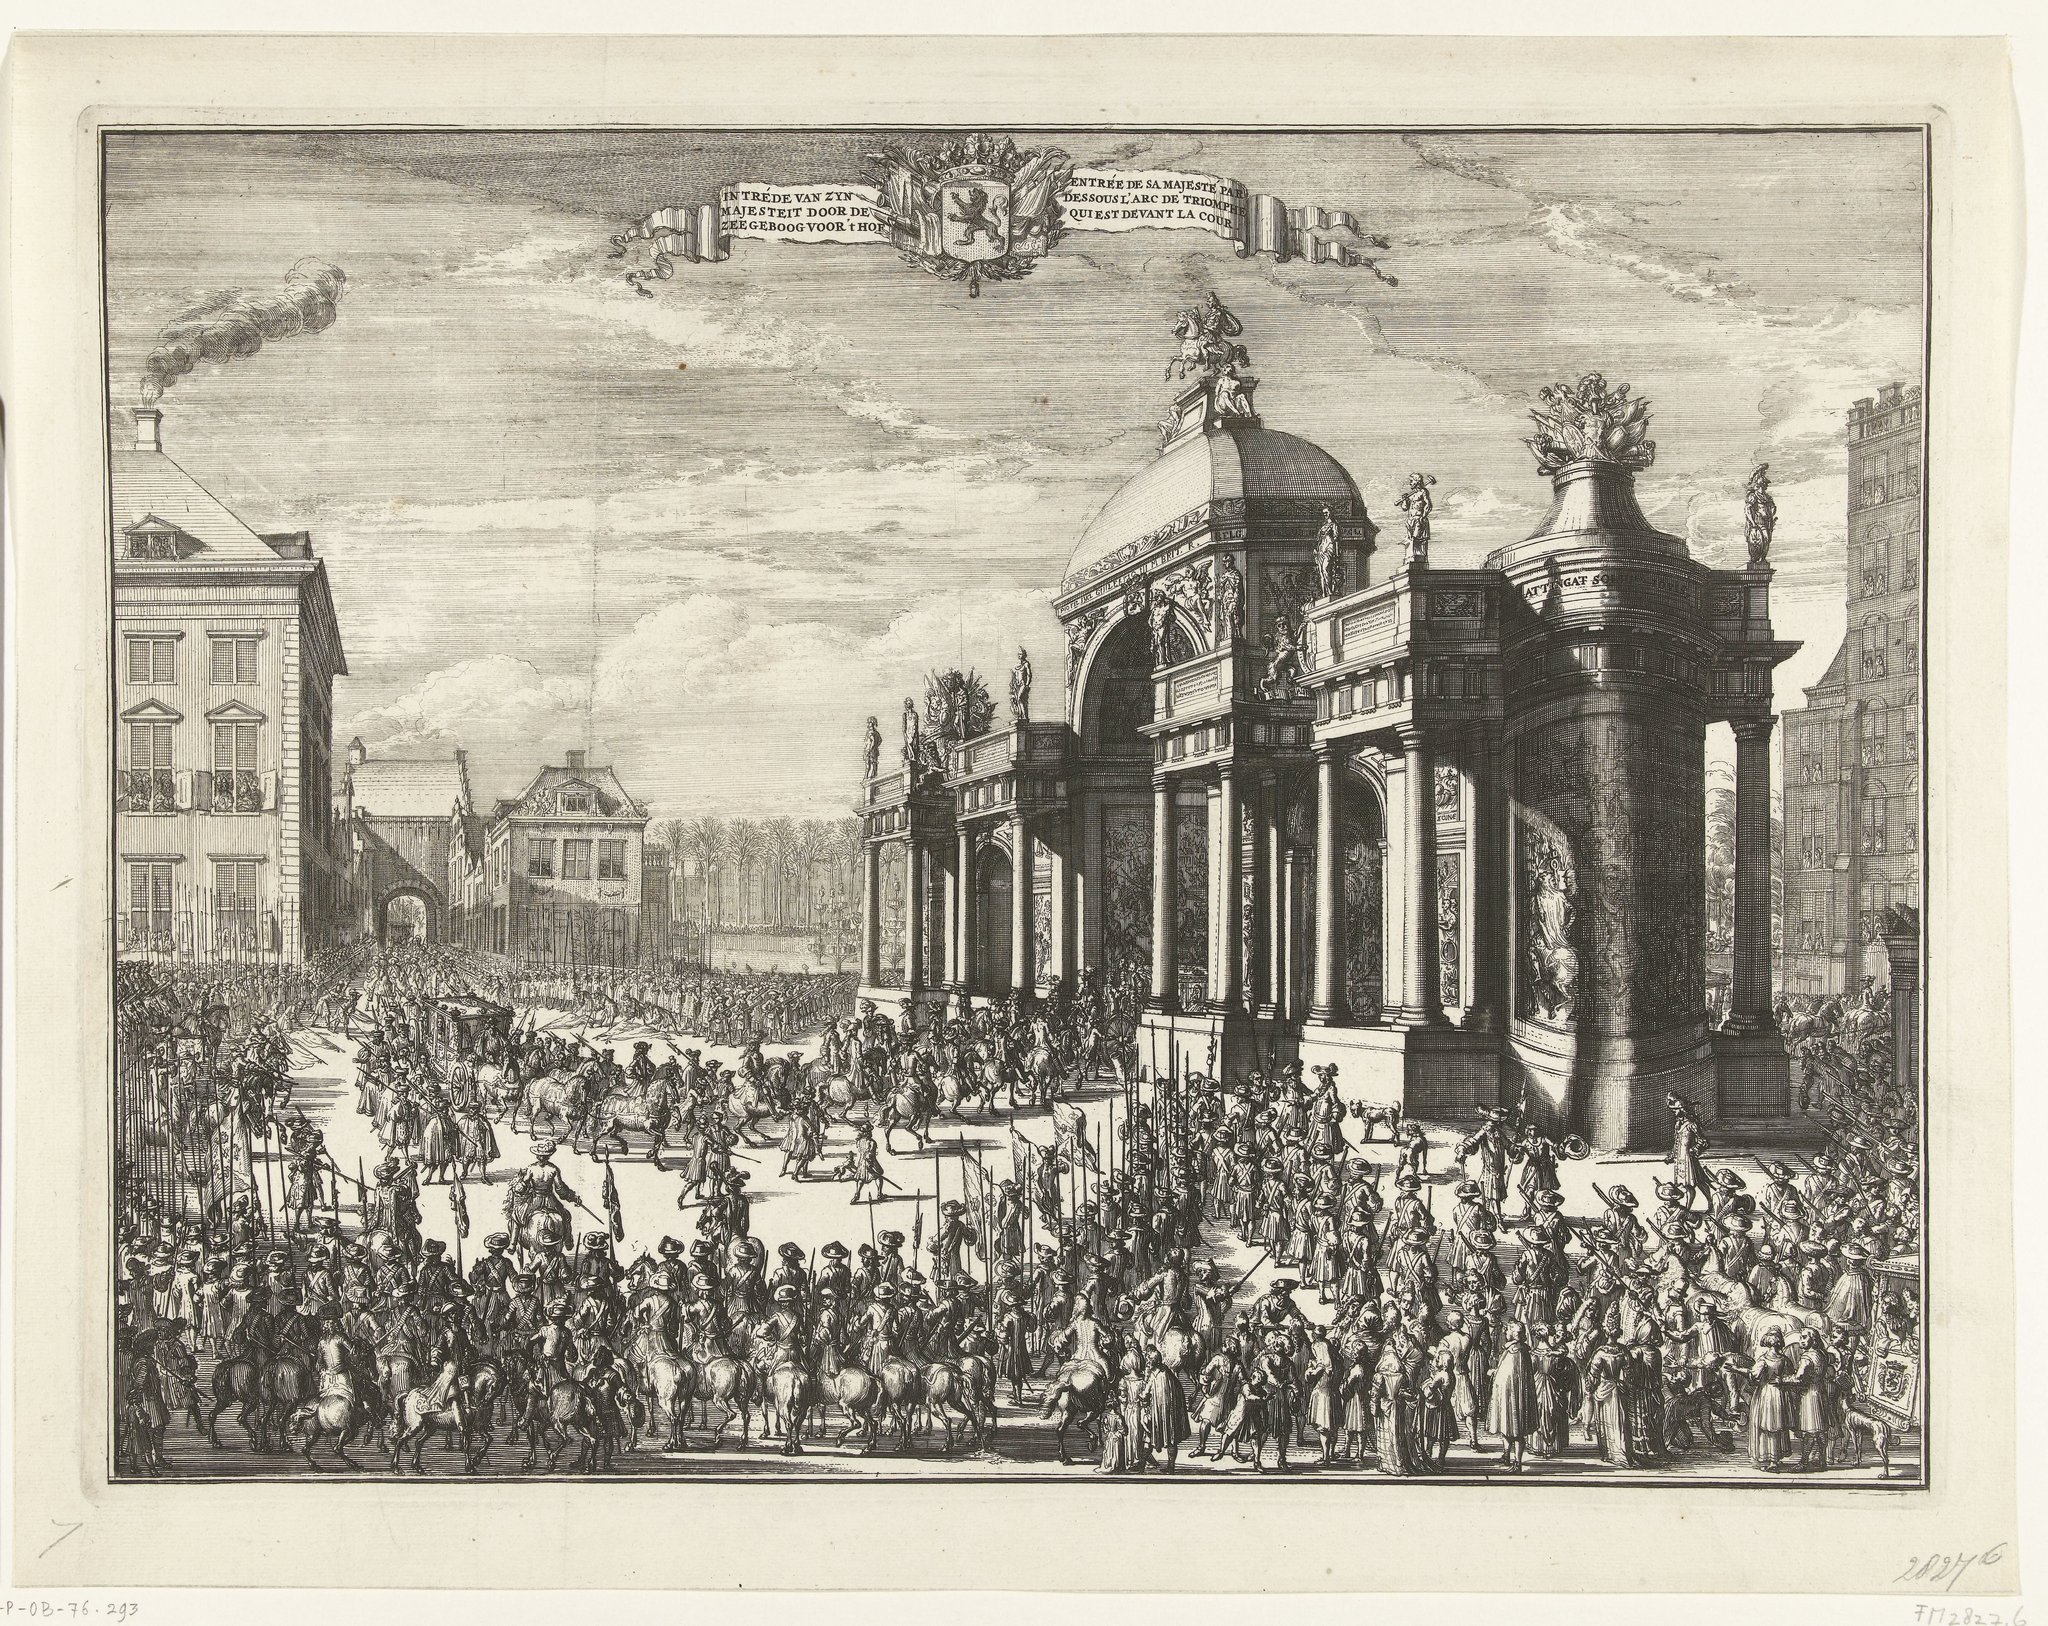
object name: print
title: Intrede van Willem III door de triomfboog bij het Buitenhof, 1691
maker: romeyn de hooghe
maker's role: draughtsman, goldsmith, painter, print maker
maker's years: 1645-1708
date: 1691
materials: paper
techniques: etching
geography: northern netherlands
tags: william iii (prince of orange and king of england, scotland, and ireland), triumphal entry and public reception, pageant, 'entrée solennelle', 'joyeuse entrée', coat of arms (as symbol of the state, etc.) (+ province; provincial)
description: Prent ook gebruikt in: Bidloo, Govard. Komste van zyne majesteit Willem III. Koning van Groot Britanje, enz. in Holland; ofte omstandelyke beschryving van alles, […] vercierd met kopere plaaten. Den Haag: Arnoud Leers, 1691.